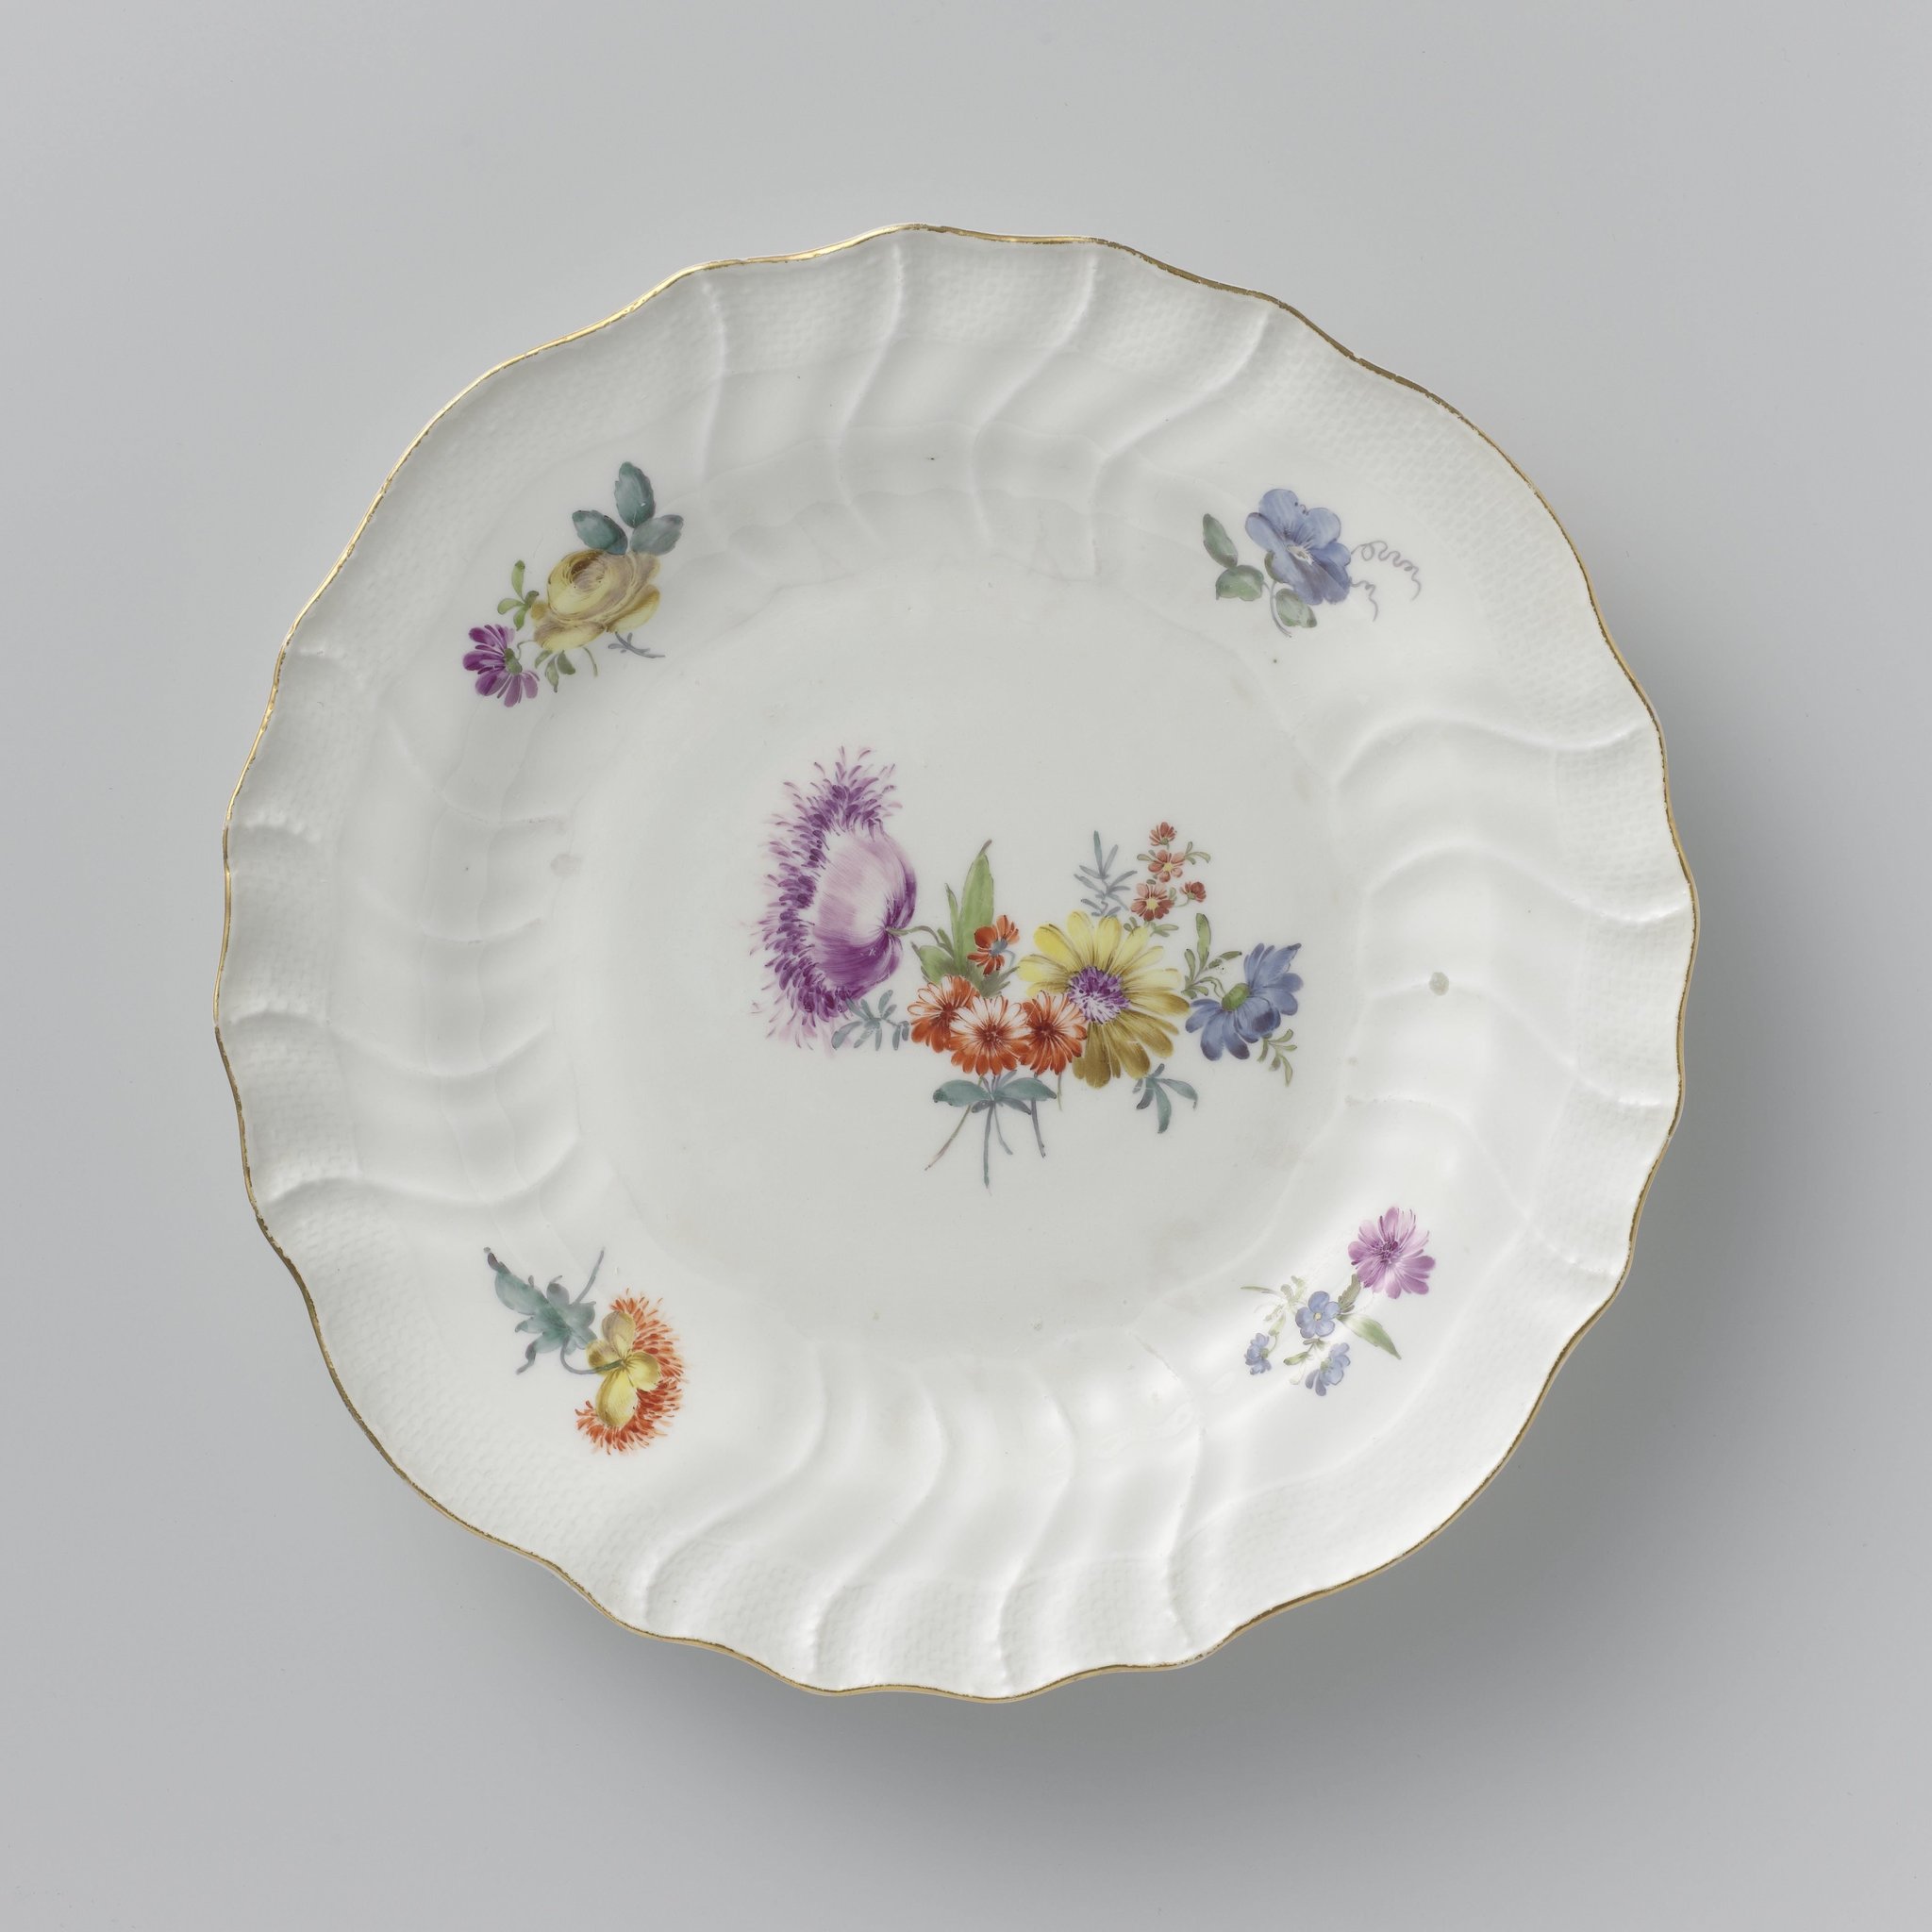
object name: eating drinking utensil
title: Bord, veelkleurig beschilderd met Deutsche Blumen, insekten en vruchten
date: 1750-1760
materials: porcelain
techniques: painted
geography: meissen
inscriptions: factory mark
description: Rond bord van beschilderd porselein. Het bord is beschilderd met Deutsche Blumen, insekten en vruchten. De rand is in reliëf versierd met het Neuozier-patroon. Het bord is gemerkt en hoort bij een servies (BK-17474-1 t/m BK-17474-253).